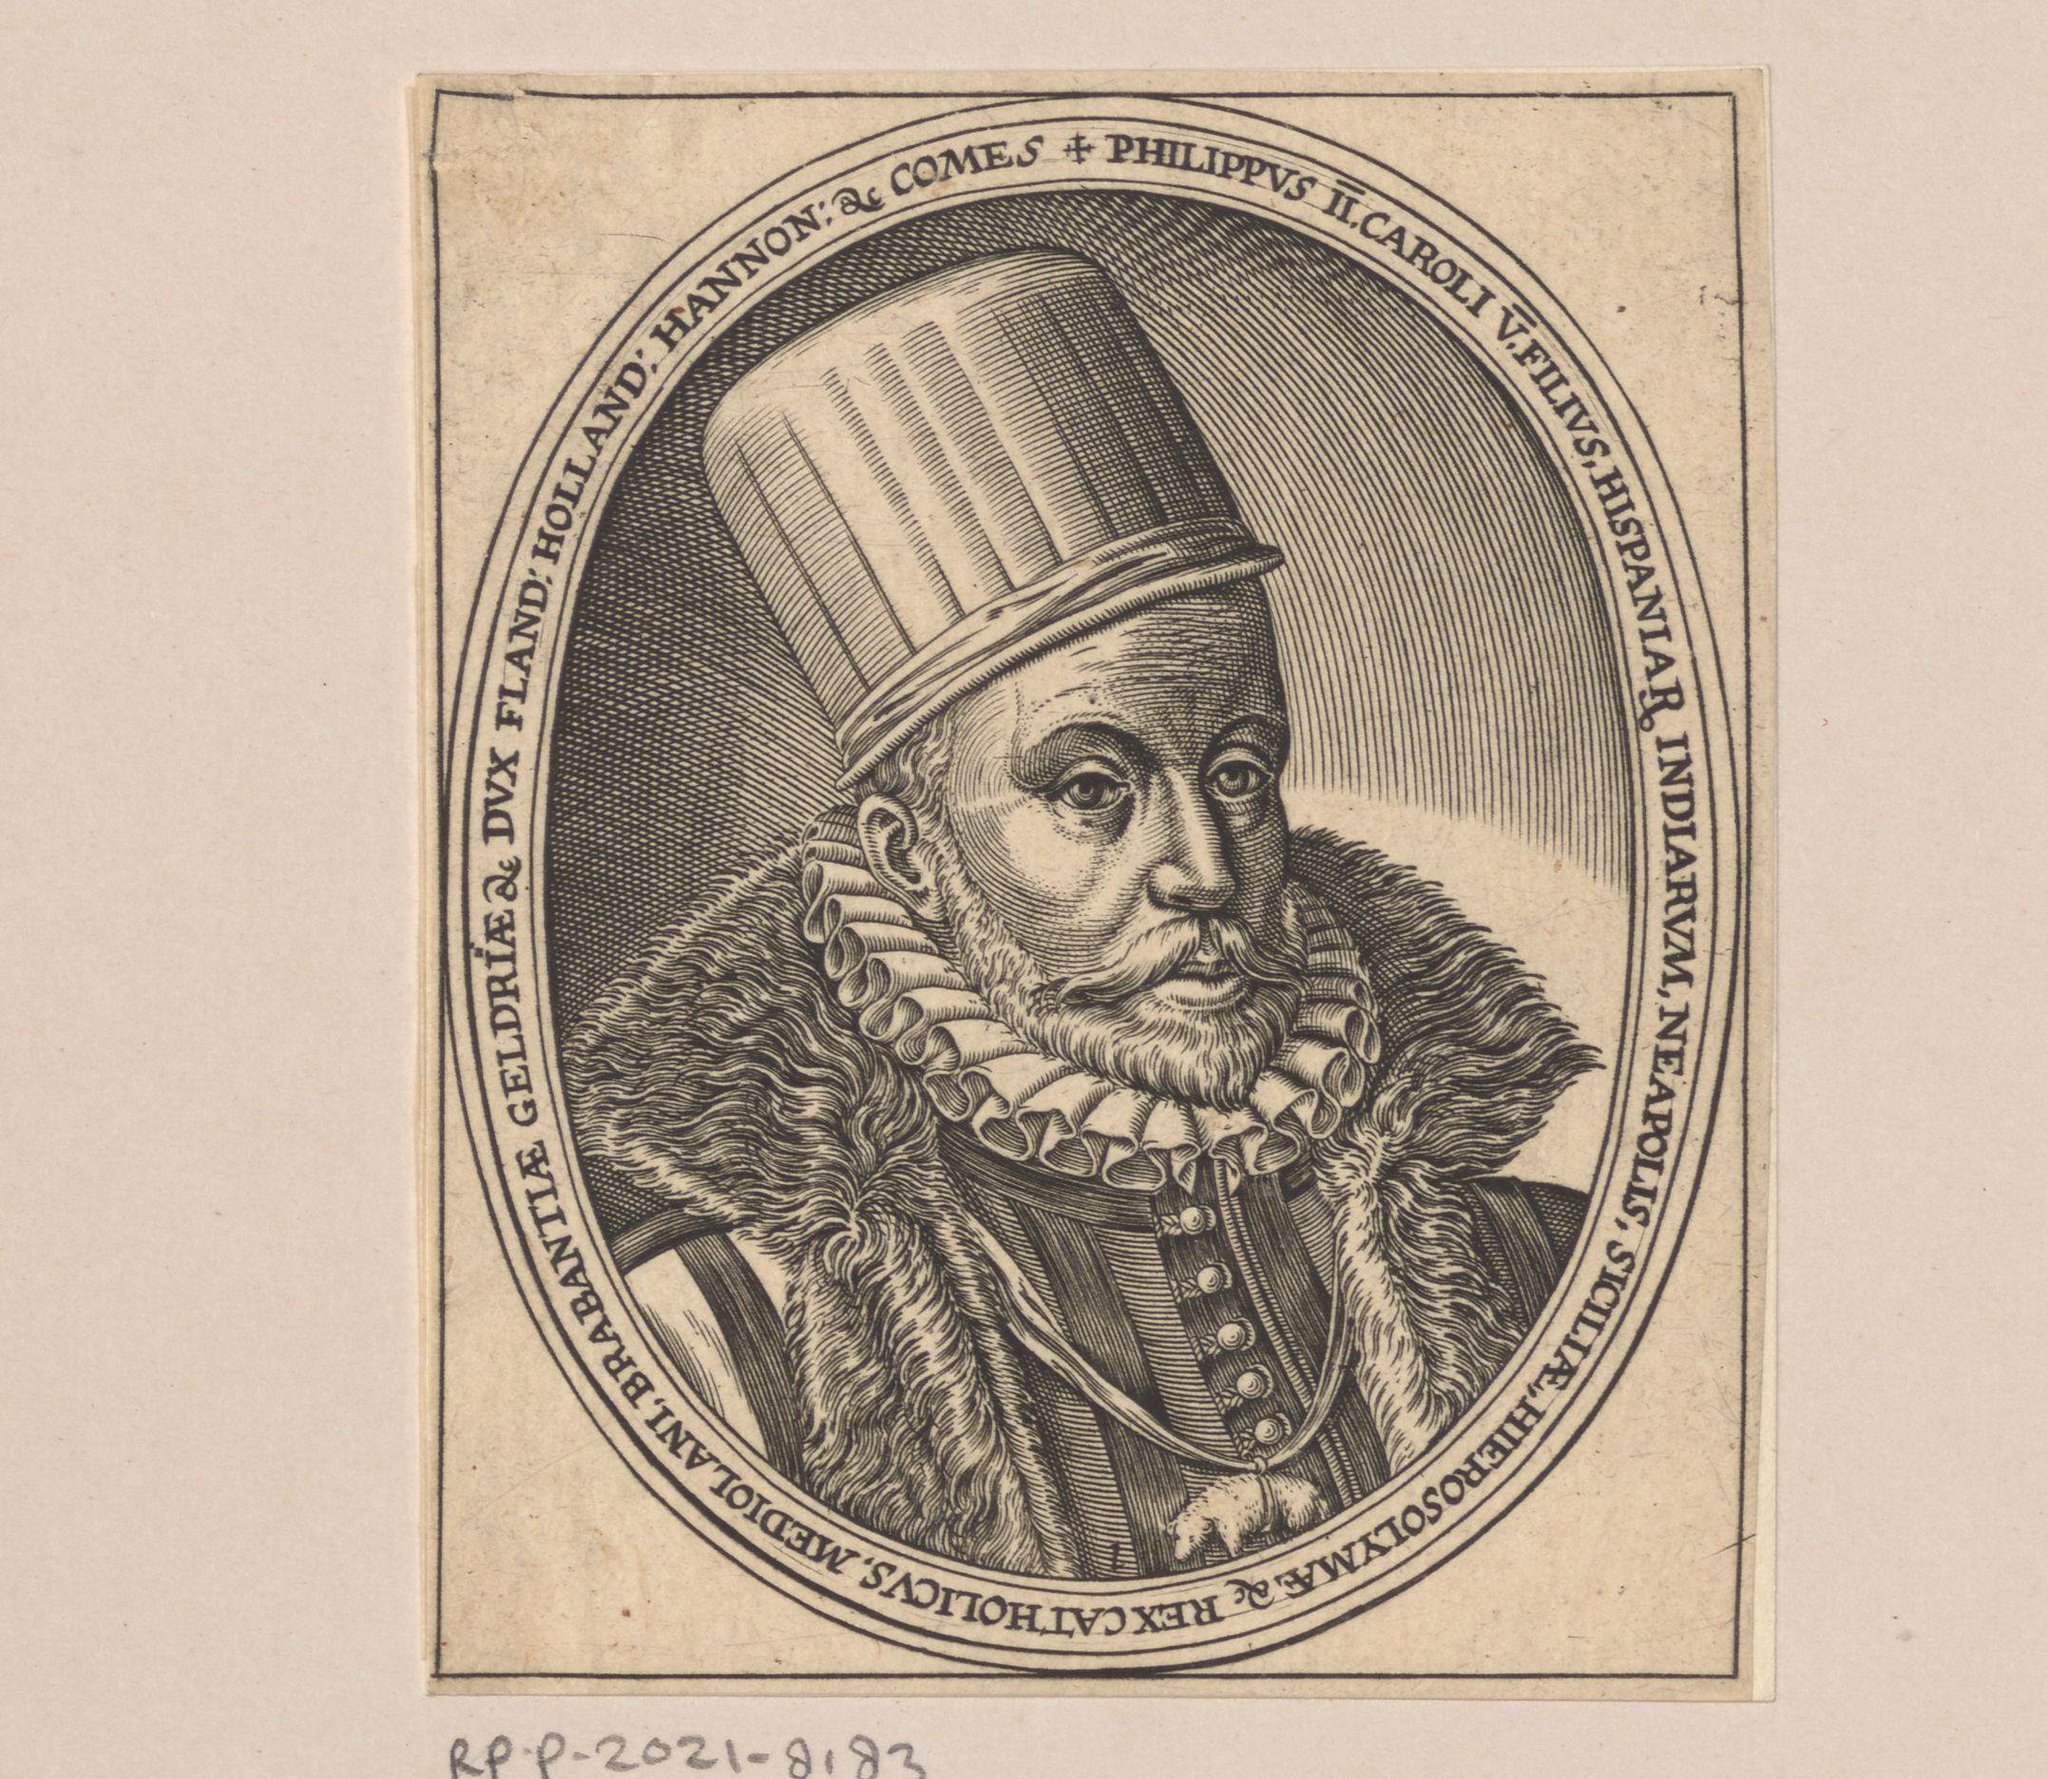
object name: print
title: Portret van Filips II, koning van Spanje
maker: Anonymous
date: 1650-1749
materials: paper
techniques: engraving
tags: philip ii of spain, historical persons, knighthood order of the golden fleece